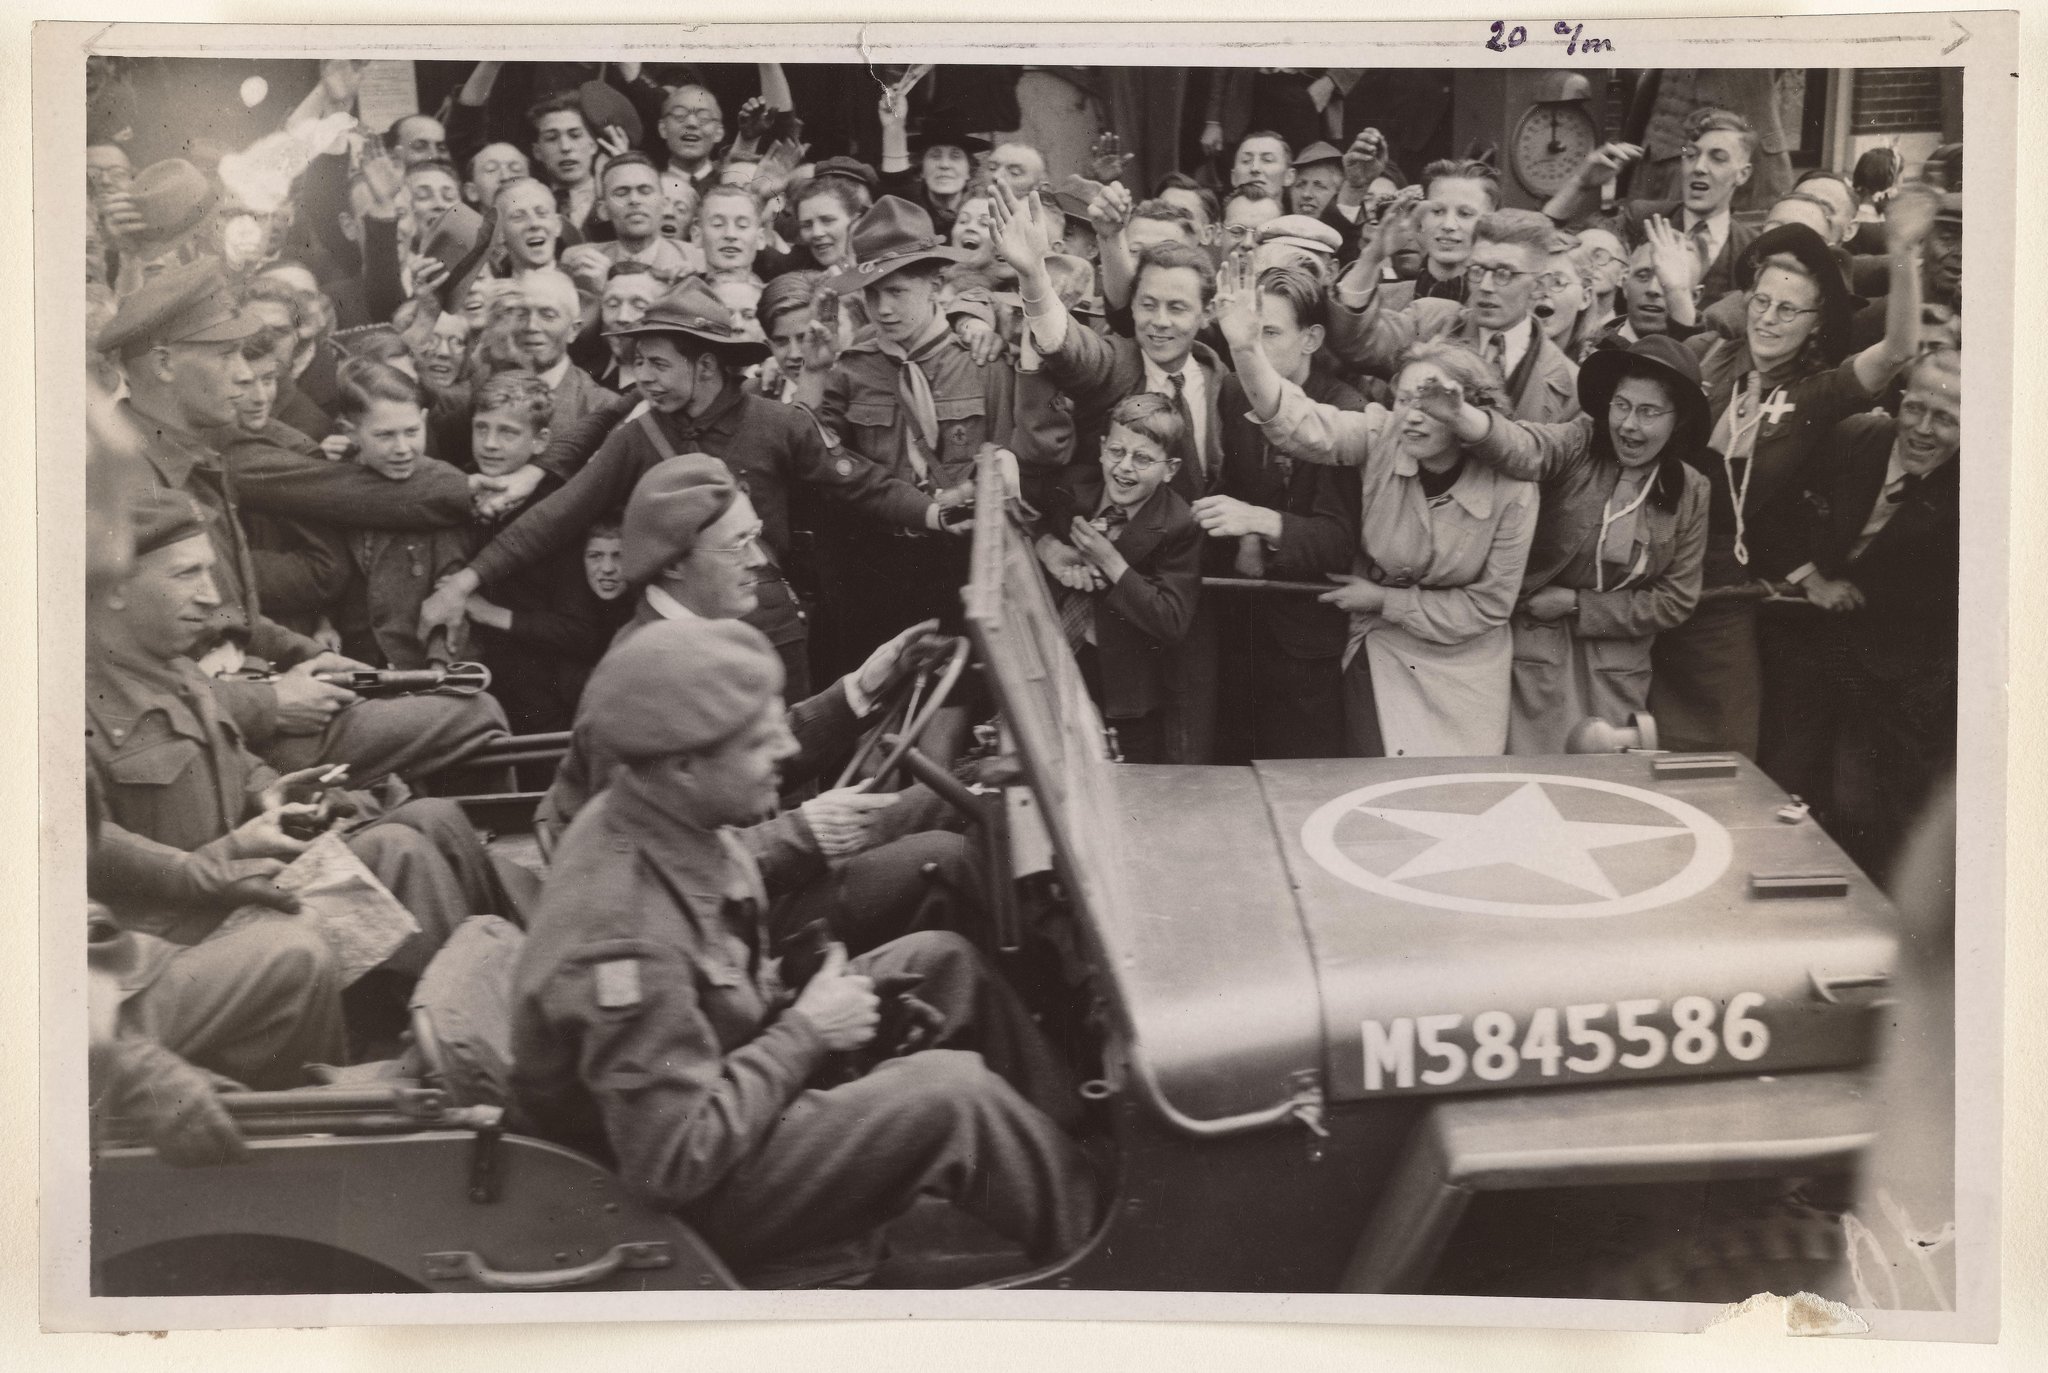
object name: photograph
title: Prins Bernhard in een jeep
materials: photographic support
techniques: photography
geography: groningen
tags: utrecht, bernhard (prins der nederlanden)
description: Prins Bernhard tijdens zijn rondreis langs verschillende steden achter het stuur van zijn jeep. Vermoedelijk in Groningen.